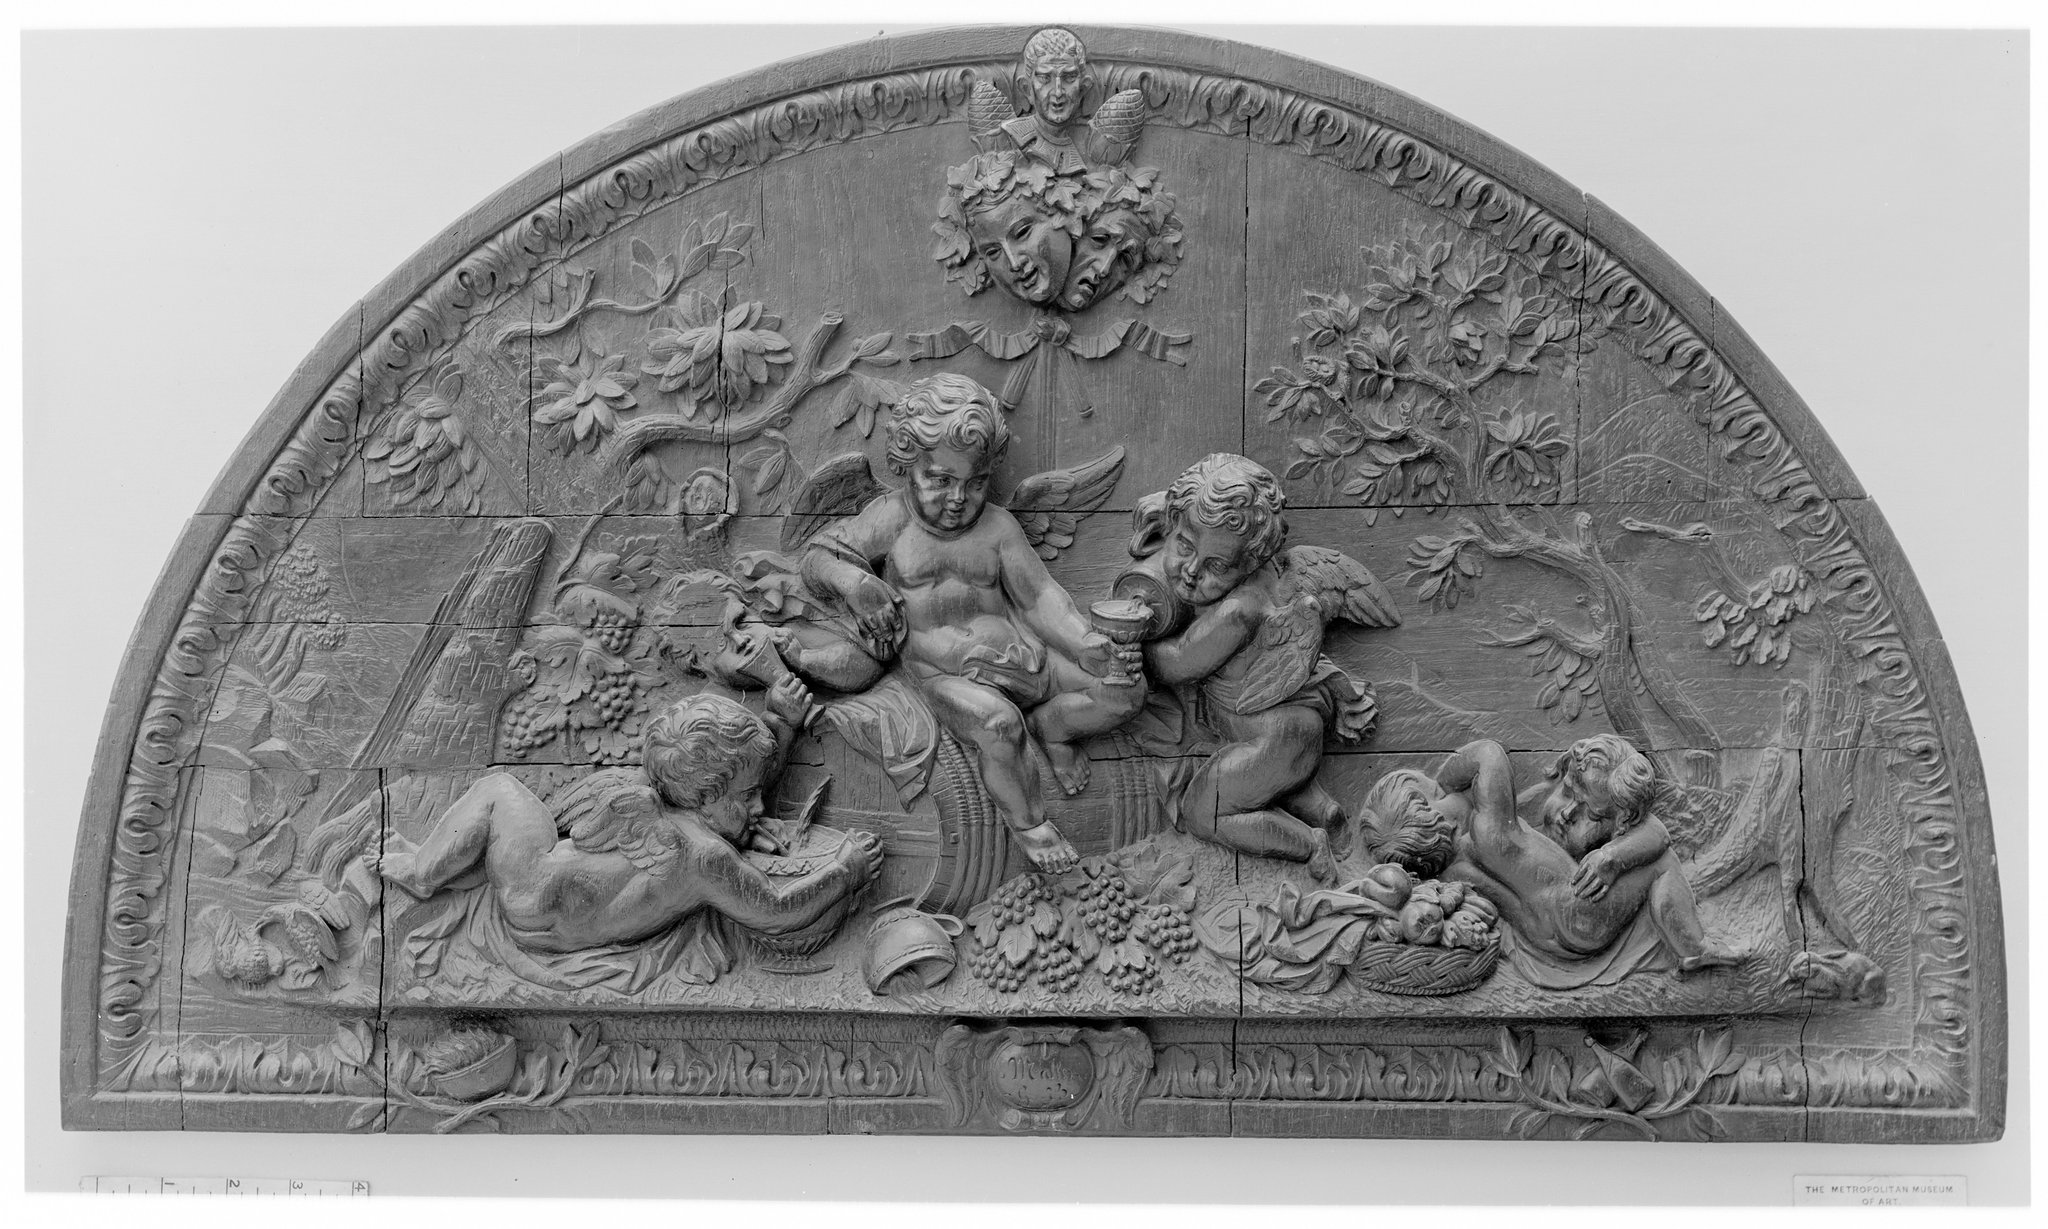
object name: panel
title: Panel (Dessus de porte)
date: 1751-1800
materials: wood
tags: wine,cupid,drinking